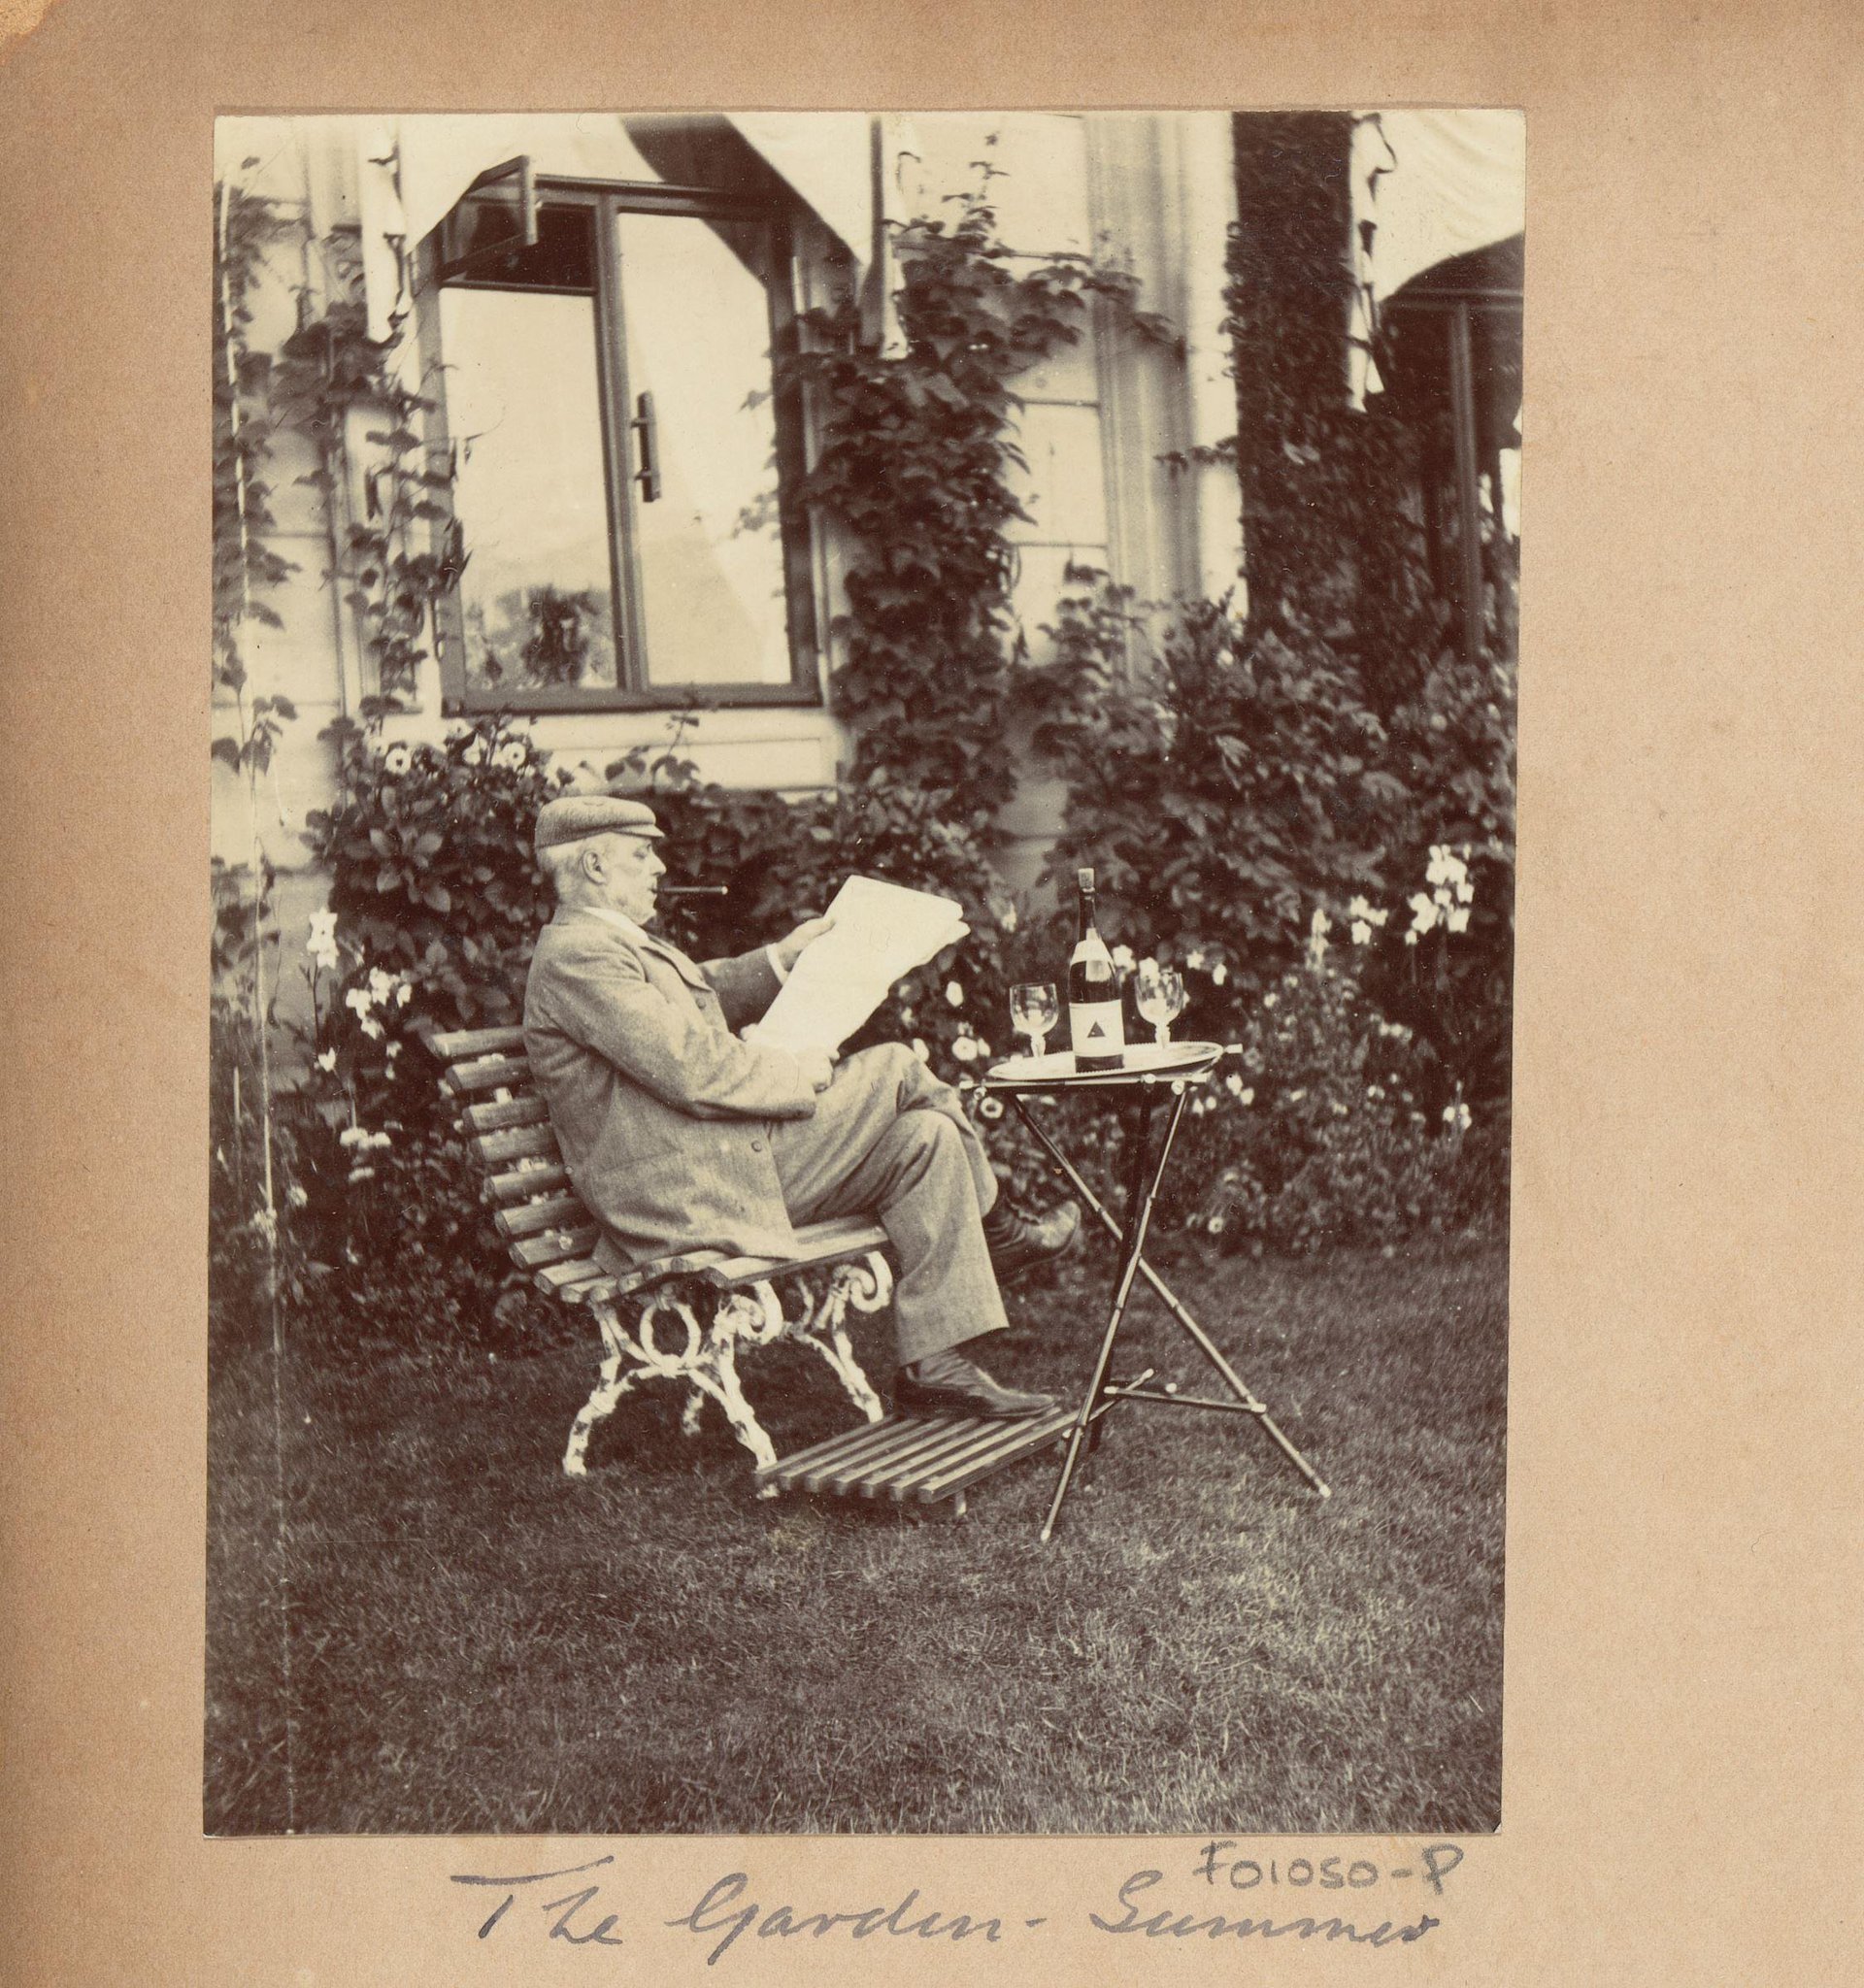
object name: photograph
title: Joseph Cheetham (vermoedelijk), de krant lezend in een tuin in Rusland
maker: joseph cheetham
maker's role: engineer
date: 1903-1904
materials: photographic support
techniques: gelatin silver print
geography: russia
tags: joseph cheetham, garden, newspaper, news-sheet, russia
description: Onderdeel van Fotoalbum van de Engelse familie Cheetham met opnames van hun verblijf in Rusland.